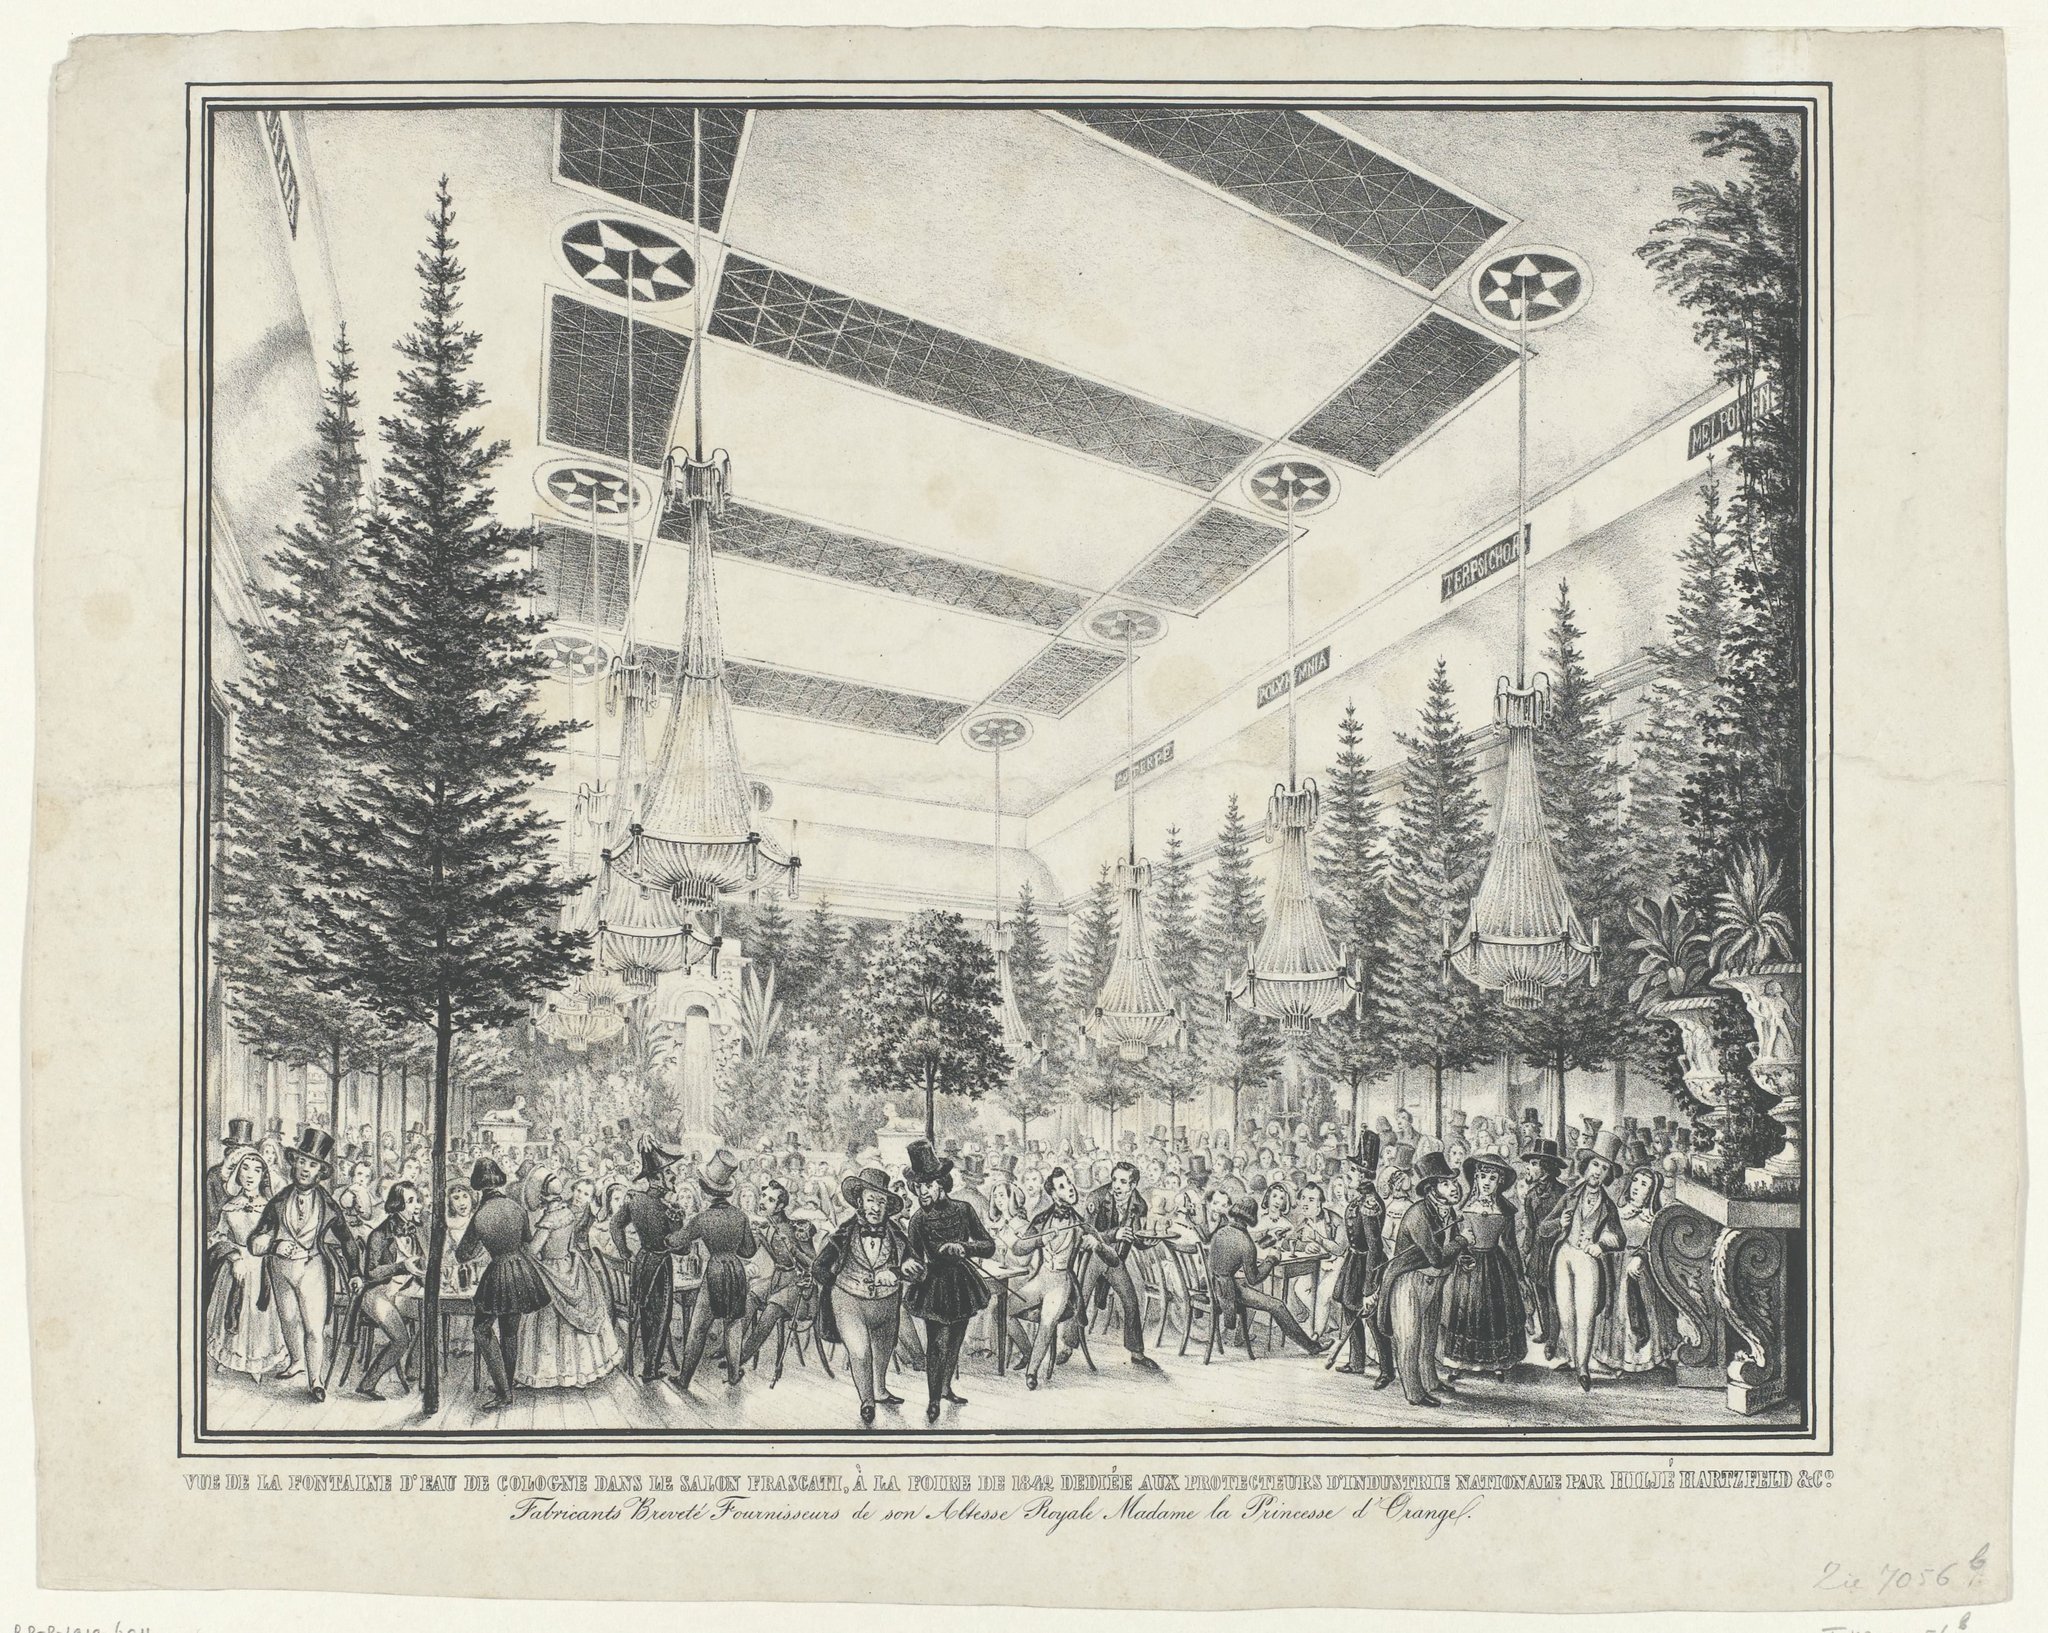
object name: print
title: Soiree in Frascati met een fontein met eau de cologne, 1842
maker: Anonymous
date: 1842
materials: paper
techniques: lithograph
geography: netherlands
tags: inn, coffee-house, public house, etc., public festivities, perfumes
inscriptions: collector's mark: Lugt 2228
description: Soiree gehouden tijdens de kermis van (september) 1842 in de salon van Frascati te Amsterdam. Groepen mensen zittend aan tafels tussen bomen. Op de achtergrond de fontein met eau de cologne. Opgedragen aan 'de beschermers van de nationale industrie'.